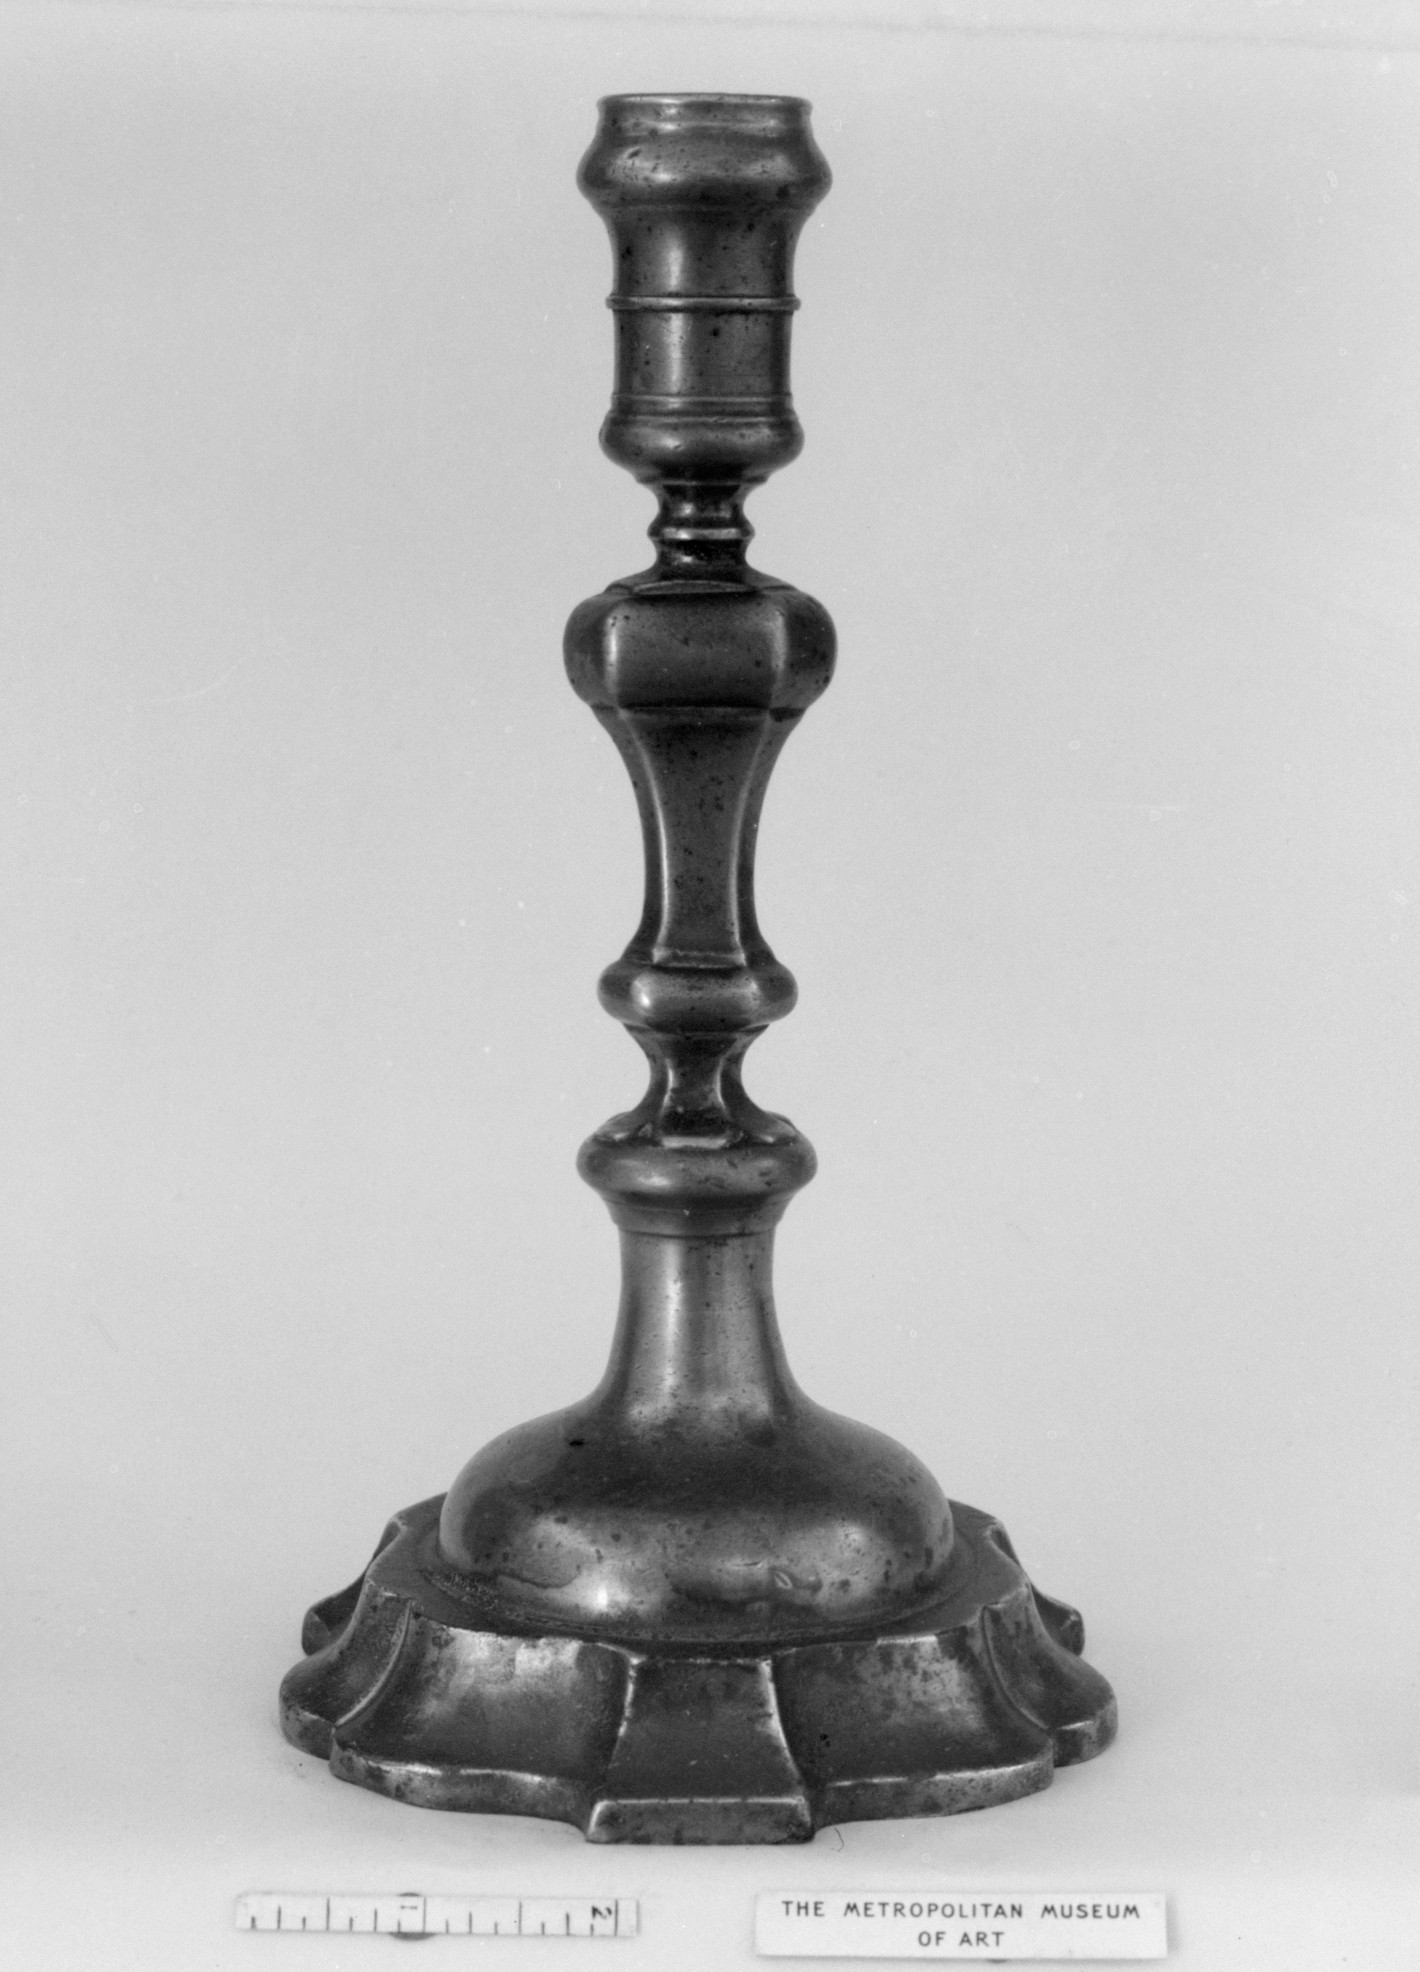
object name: candlestick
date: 1701-1800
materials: pewter